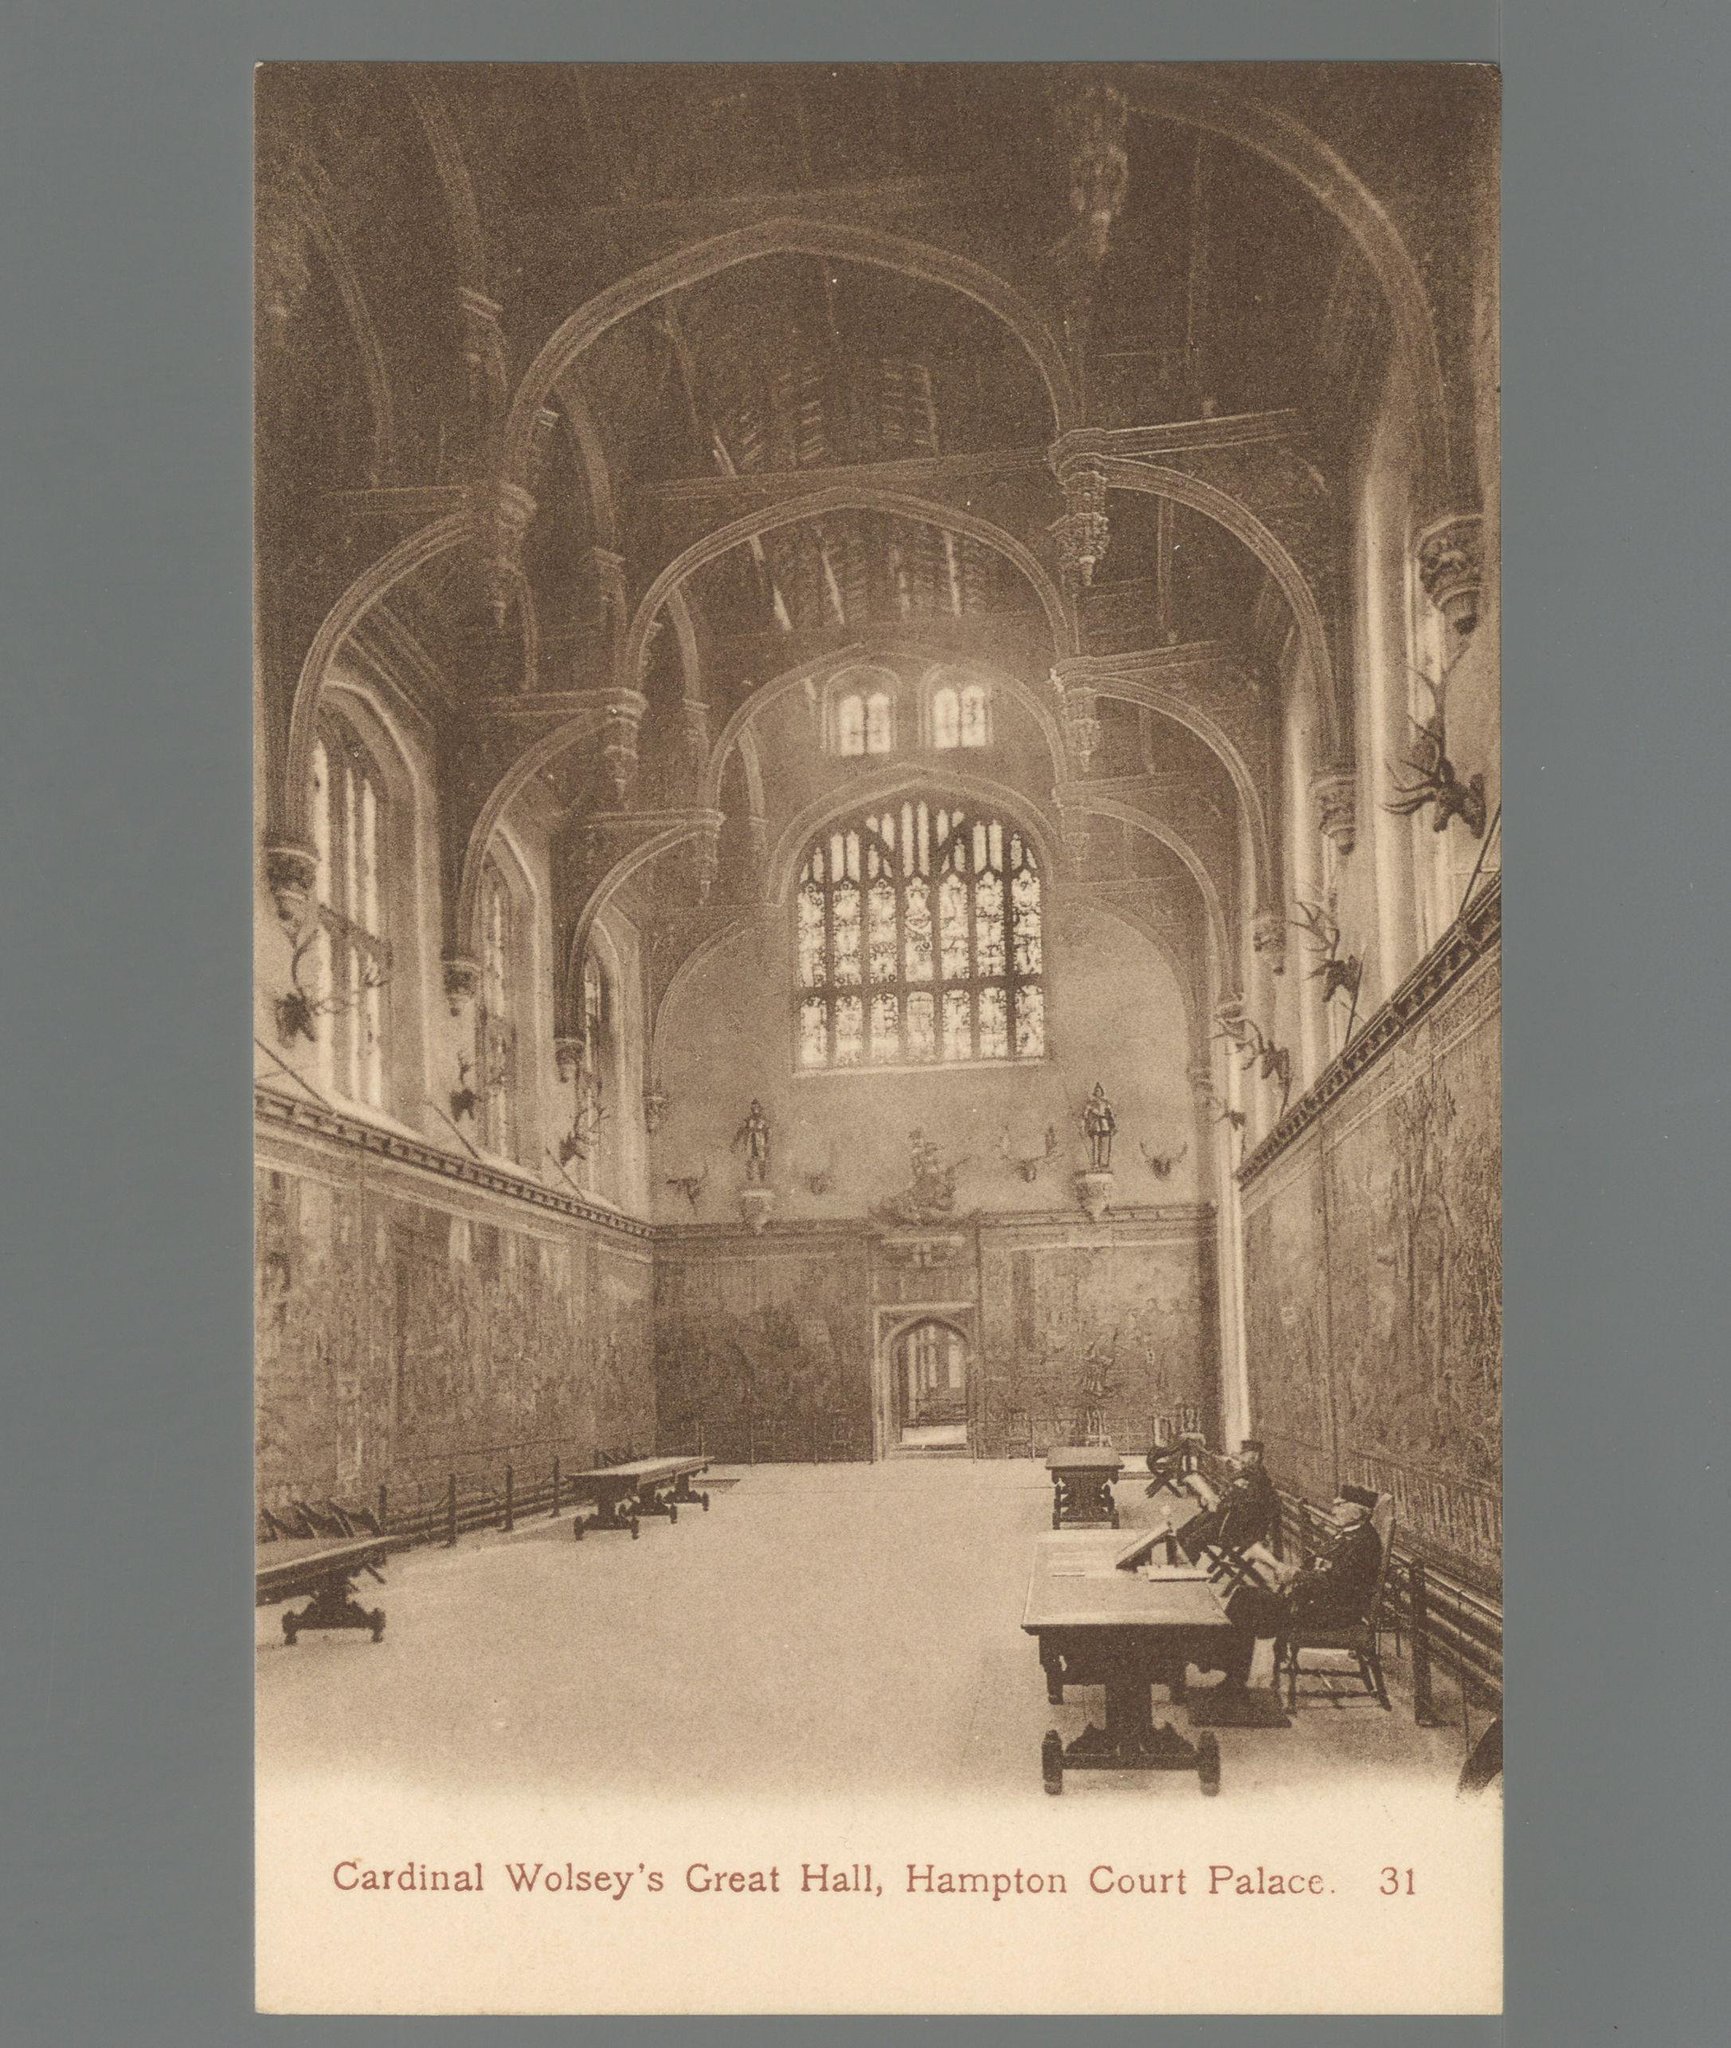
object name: photomechanical print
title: Cardinal Wolsey's Great Hall, Hampton Court Palace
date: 1902-1930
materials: cardboard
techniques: photograph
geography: hampton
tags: palace, interior of the house